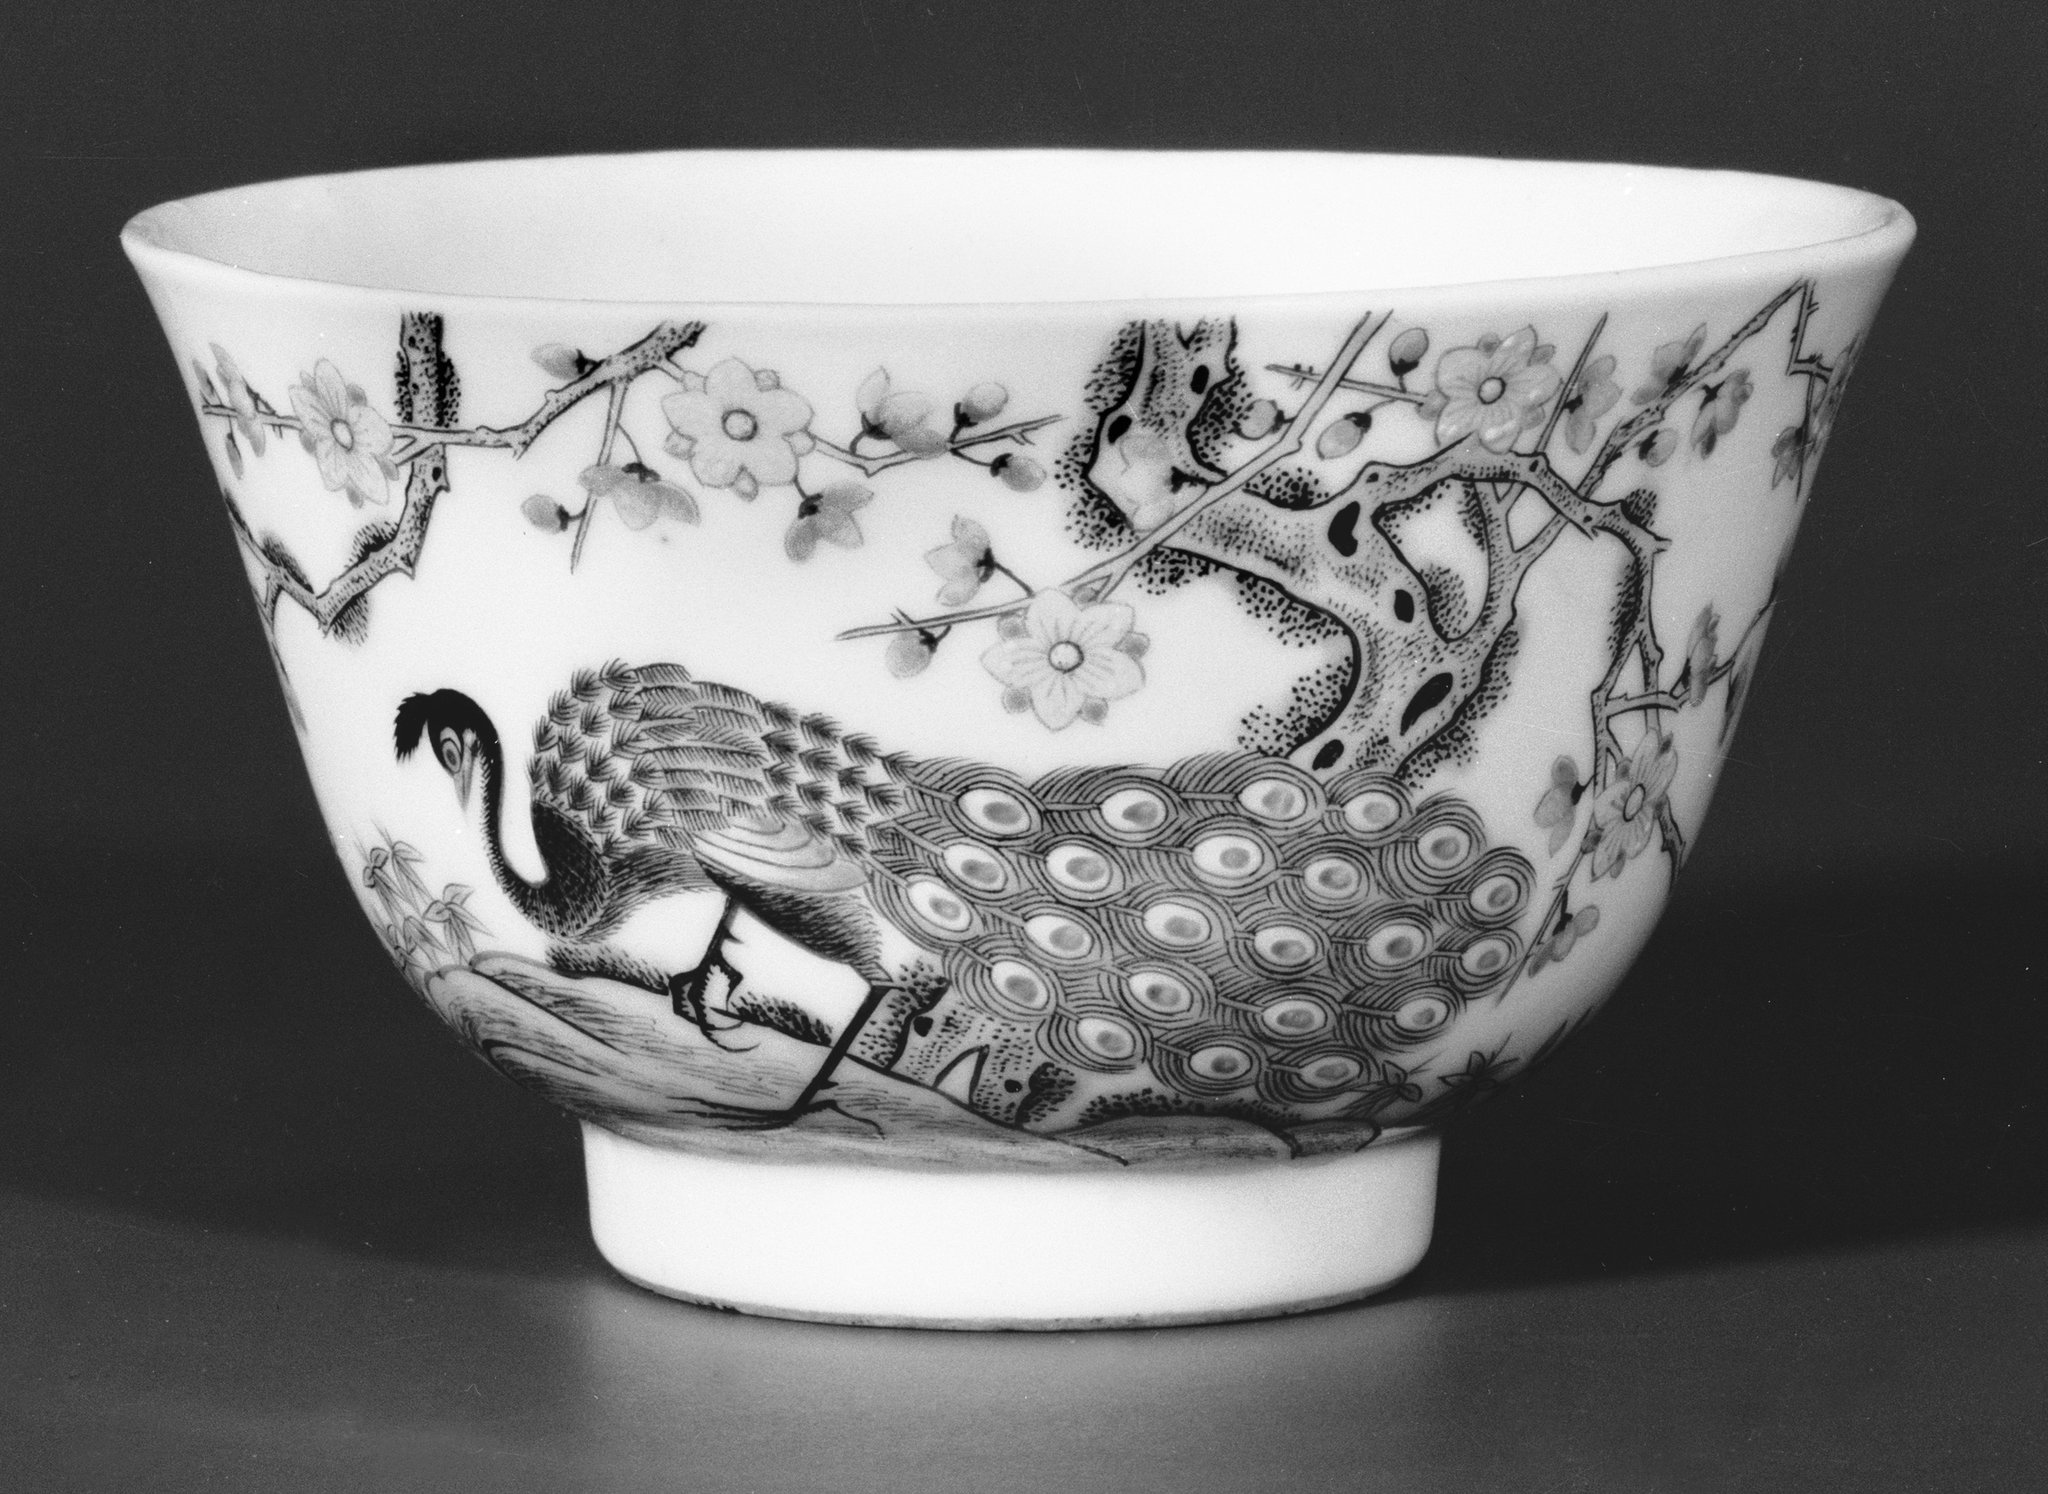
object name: bowl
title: Bowl with peacock (one of a pair)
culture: chinese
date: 1867-1933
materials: enamel, porcelain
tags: peacocks